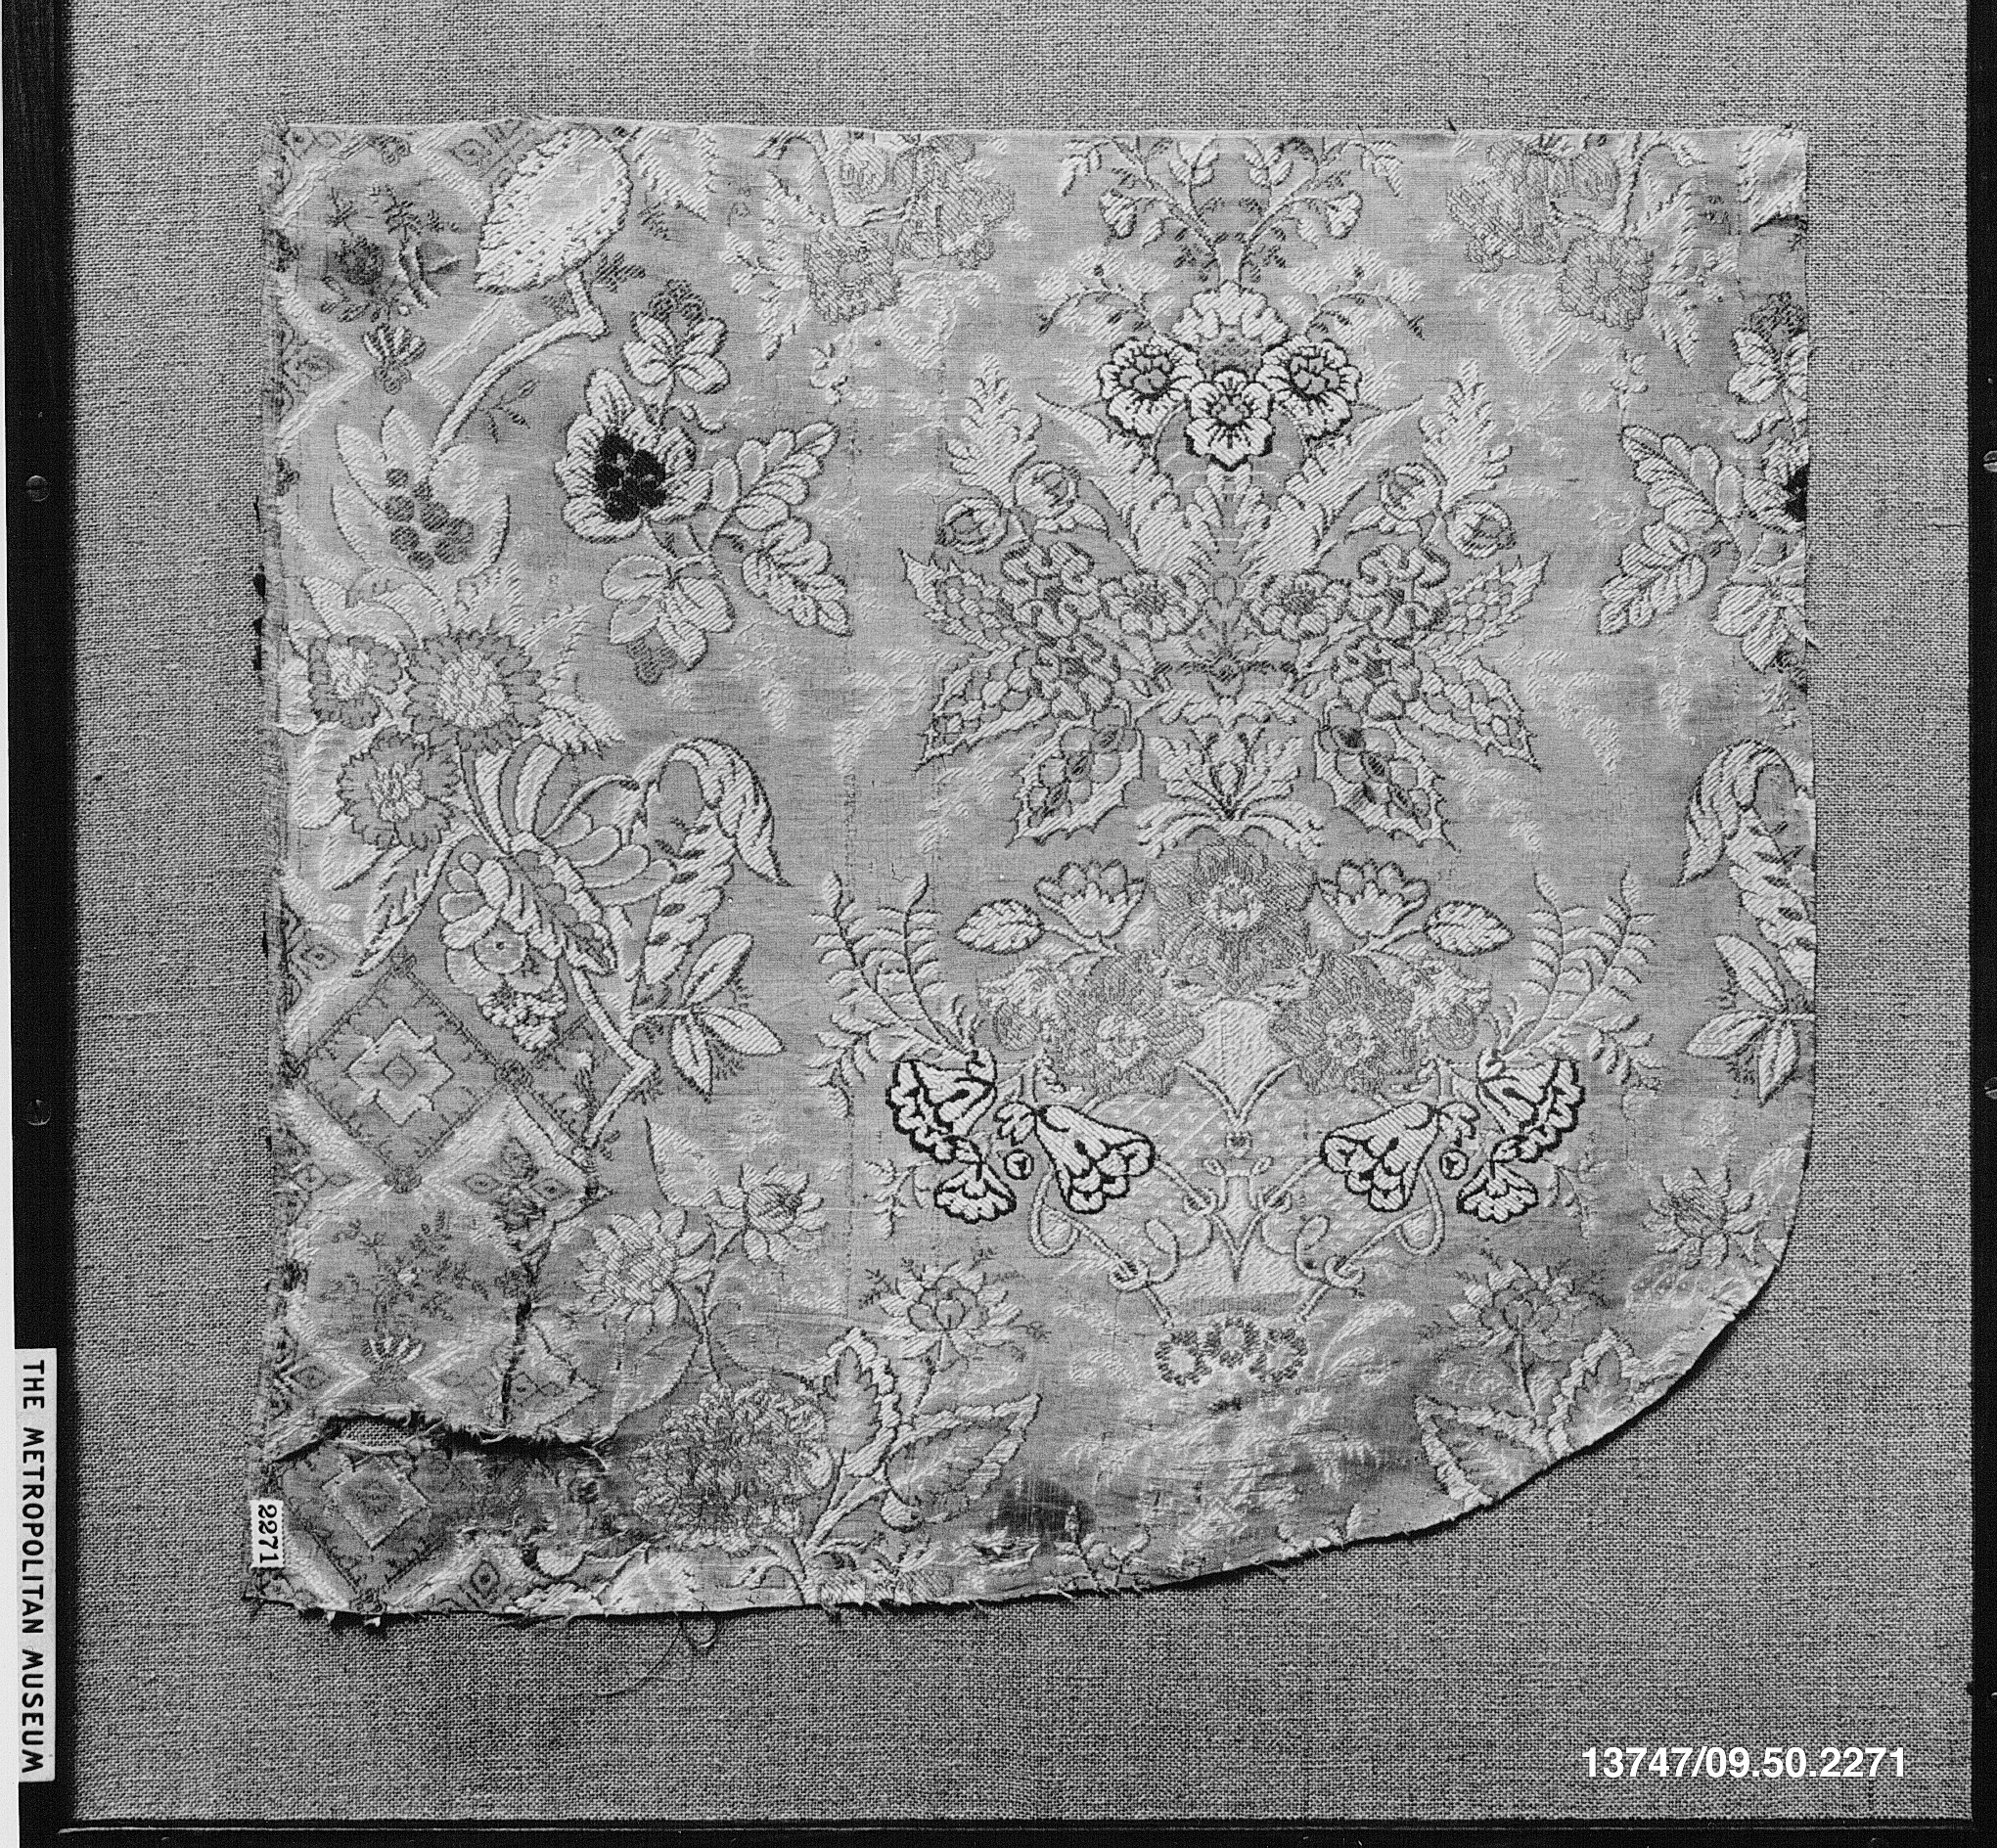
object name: piece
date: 1725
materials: silk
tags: flowers,leaves